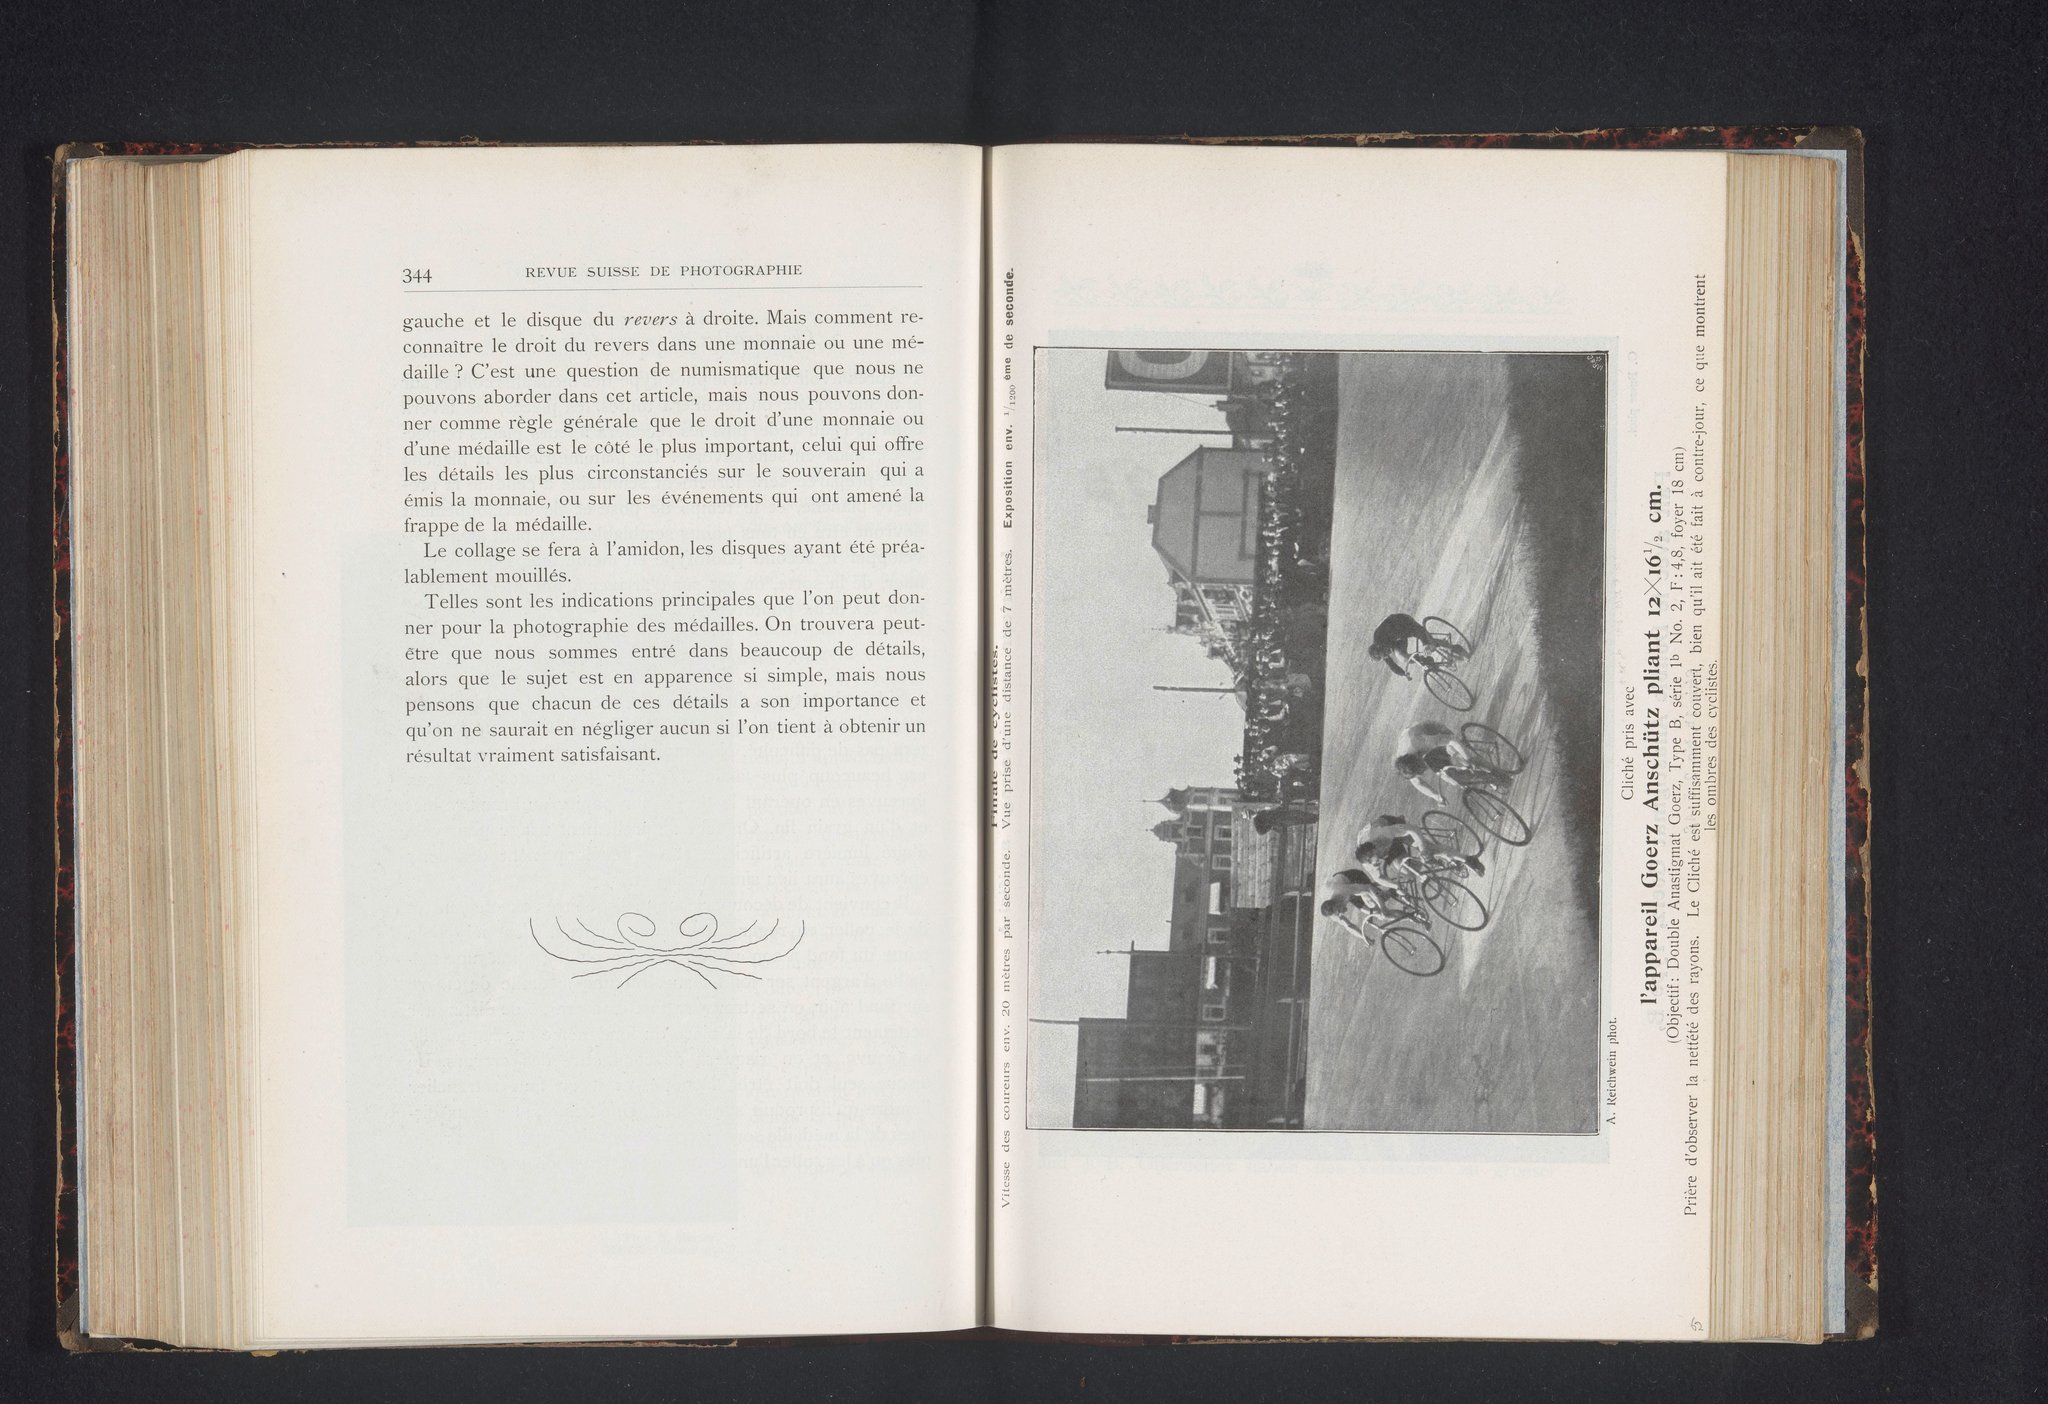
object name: page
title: Finale de cyclistes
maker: a. reichwein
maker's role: fotograaf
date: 1897-1902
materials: paper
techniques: autotype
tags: bicycle racing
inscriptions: inscription: ‘Vitesse des coureurs env. 20 mètres par seconde. Vue prise d'une distance de 7 mètres. Exposition env. 1/250 eme de seconde (...)’, monogram: ‘M.R.Co’